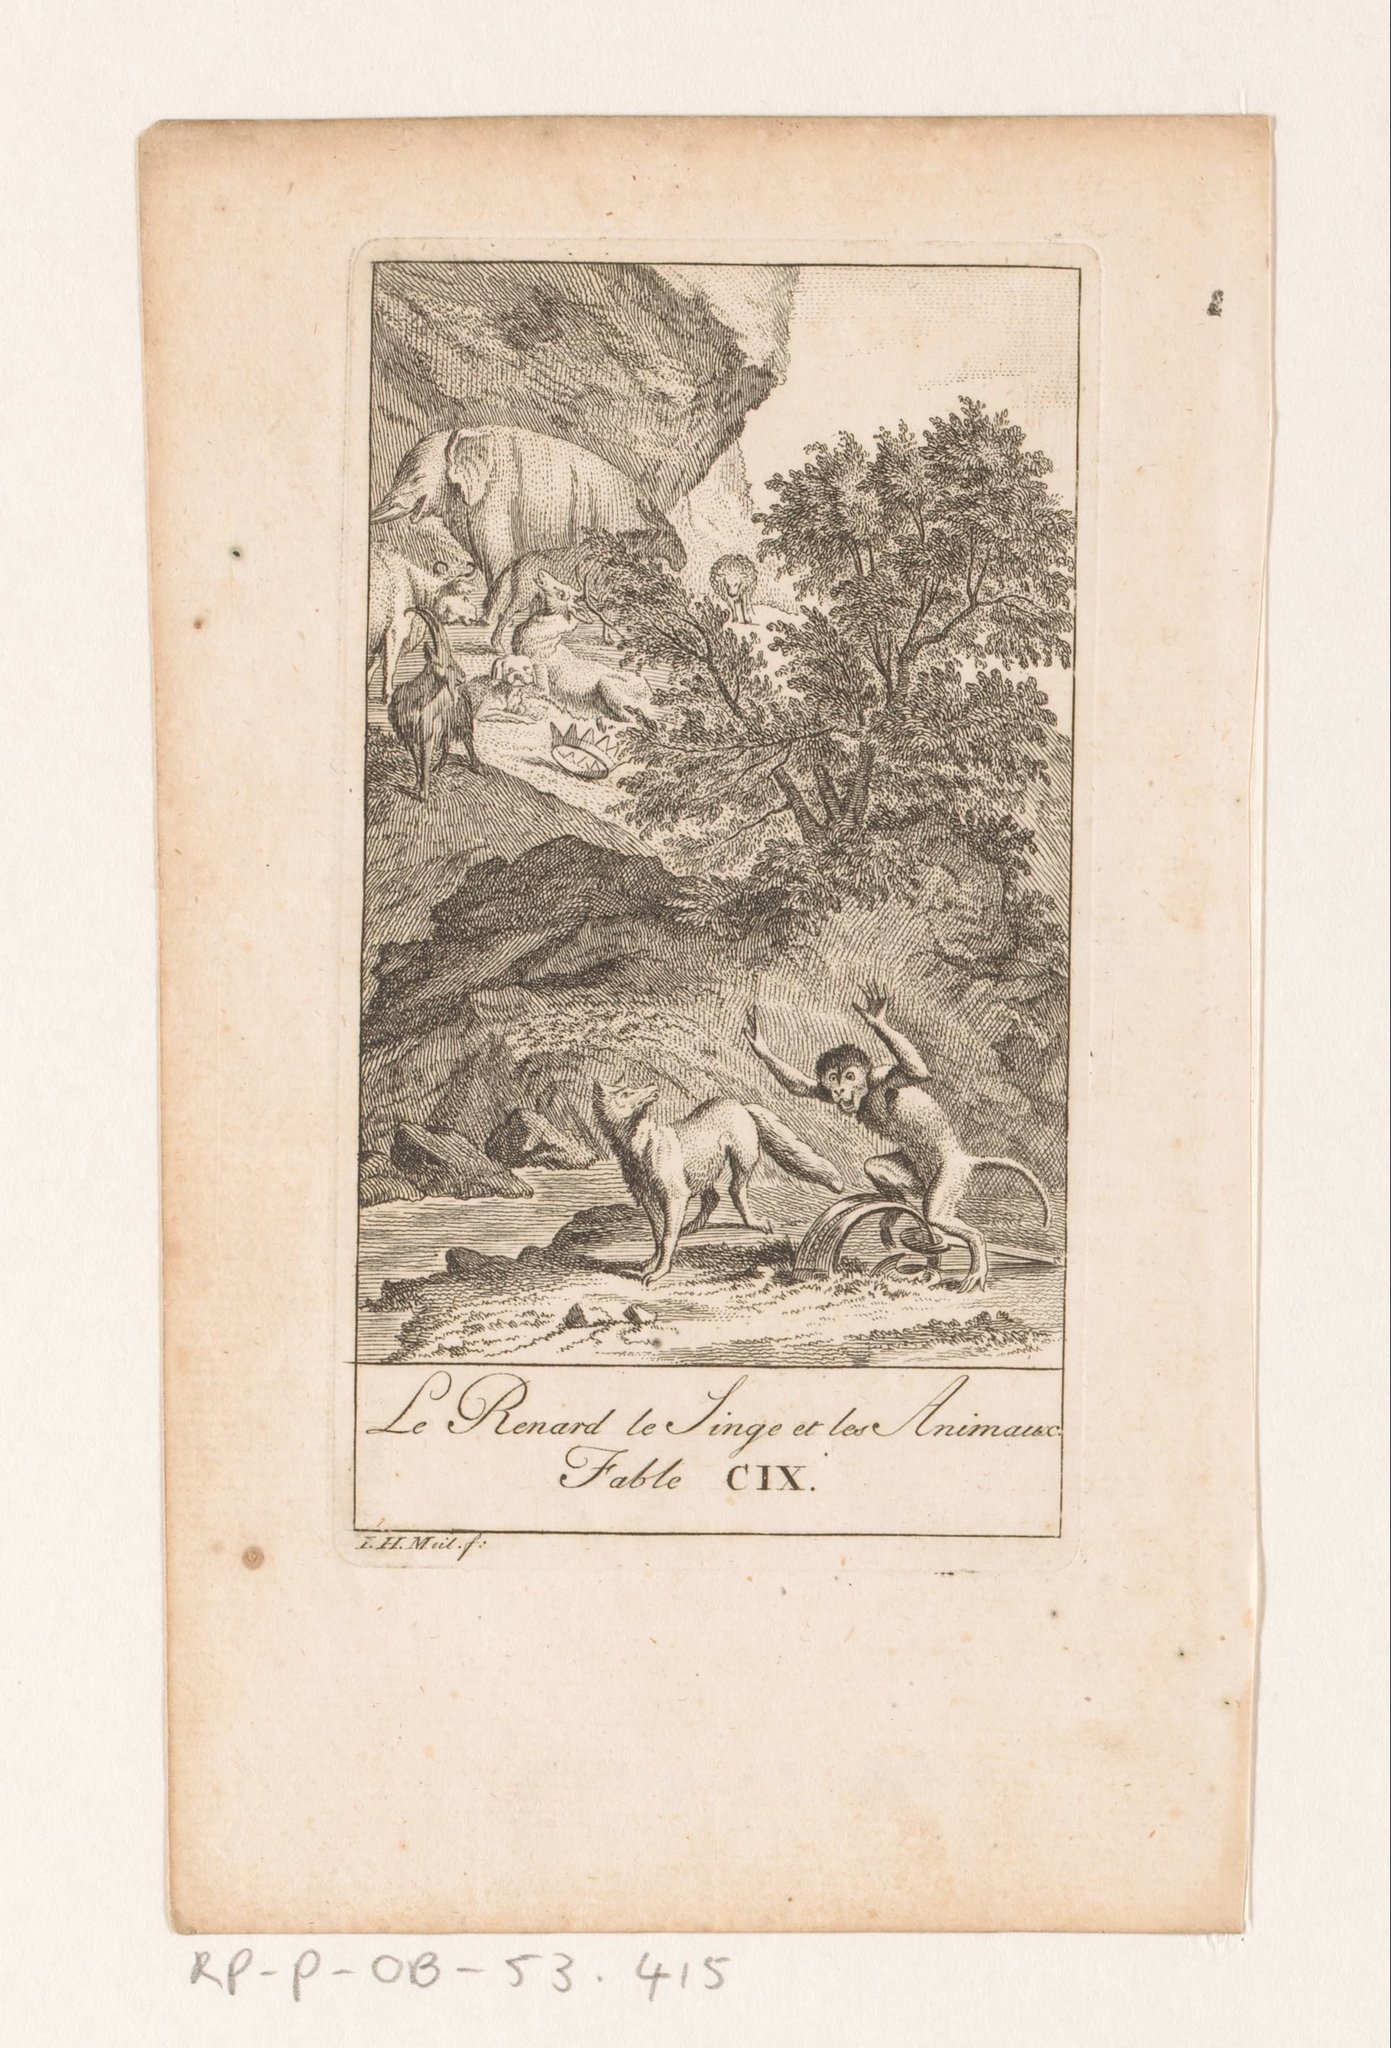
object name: print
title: Fabels van J. de la Fontaine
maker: johann heinrich meil (der ältere)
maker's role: print maker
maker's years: 1730-1820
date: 1758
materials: paper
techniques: etching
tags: fables of lafontaine : use 85(...), animals, monkeys, apes, beasts of prey, predatory animals: fox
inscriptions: collector's mark: Lugt 2228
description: Illustratie uit: Fontaine, J. de la. Fables choisies, mises en vers. Dl. 2. Dresden & Leipzig: George Conrad Walther, 1758.